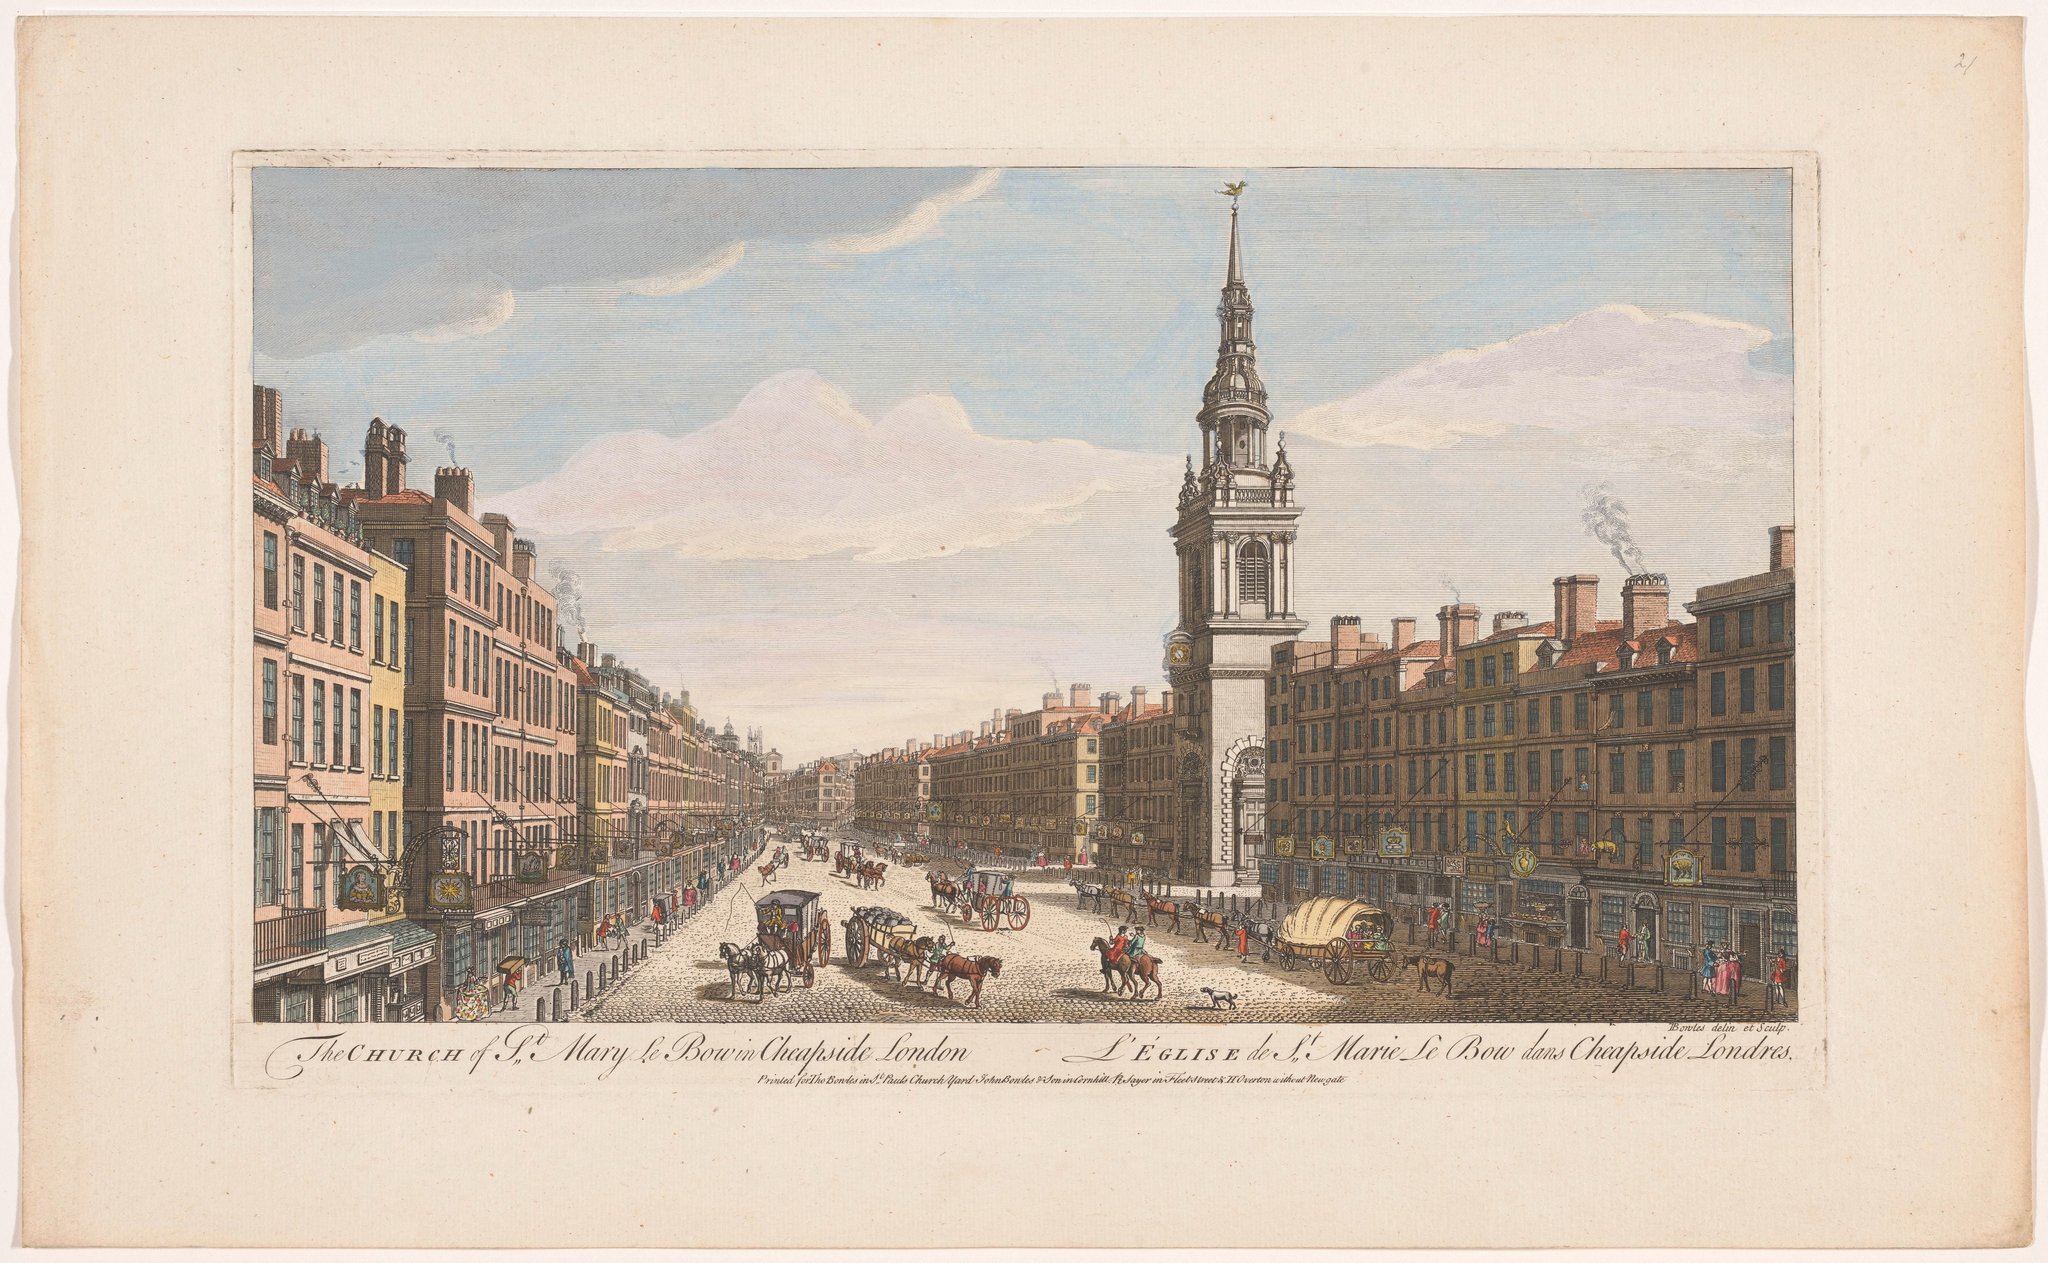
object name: print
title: The church of St. Mary le Bow in Cheapside London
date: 1745-1753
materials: paper, watercolor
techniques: brush, etching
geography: london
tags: church (exterior), street (+ city(-scape) with figures, staffage)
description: De serie “Londen” bevat 52 prenten met de nummers 1-52, waarvan dit nummer 21 is.